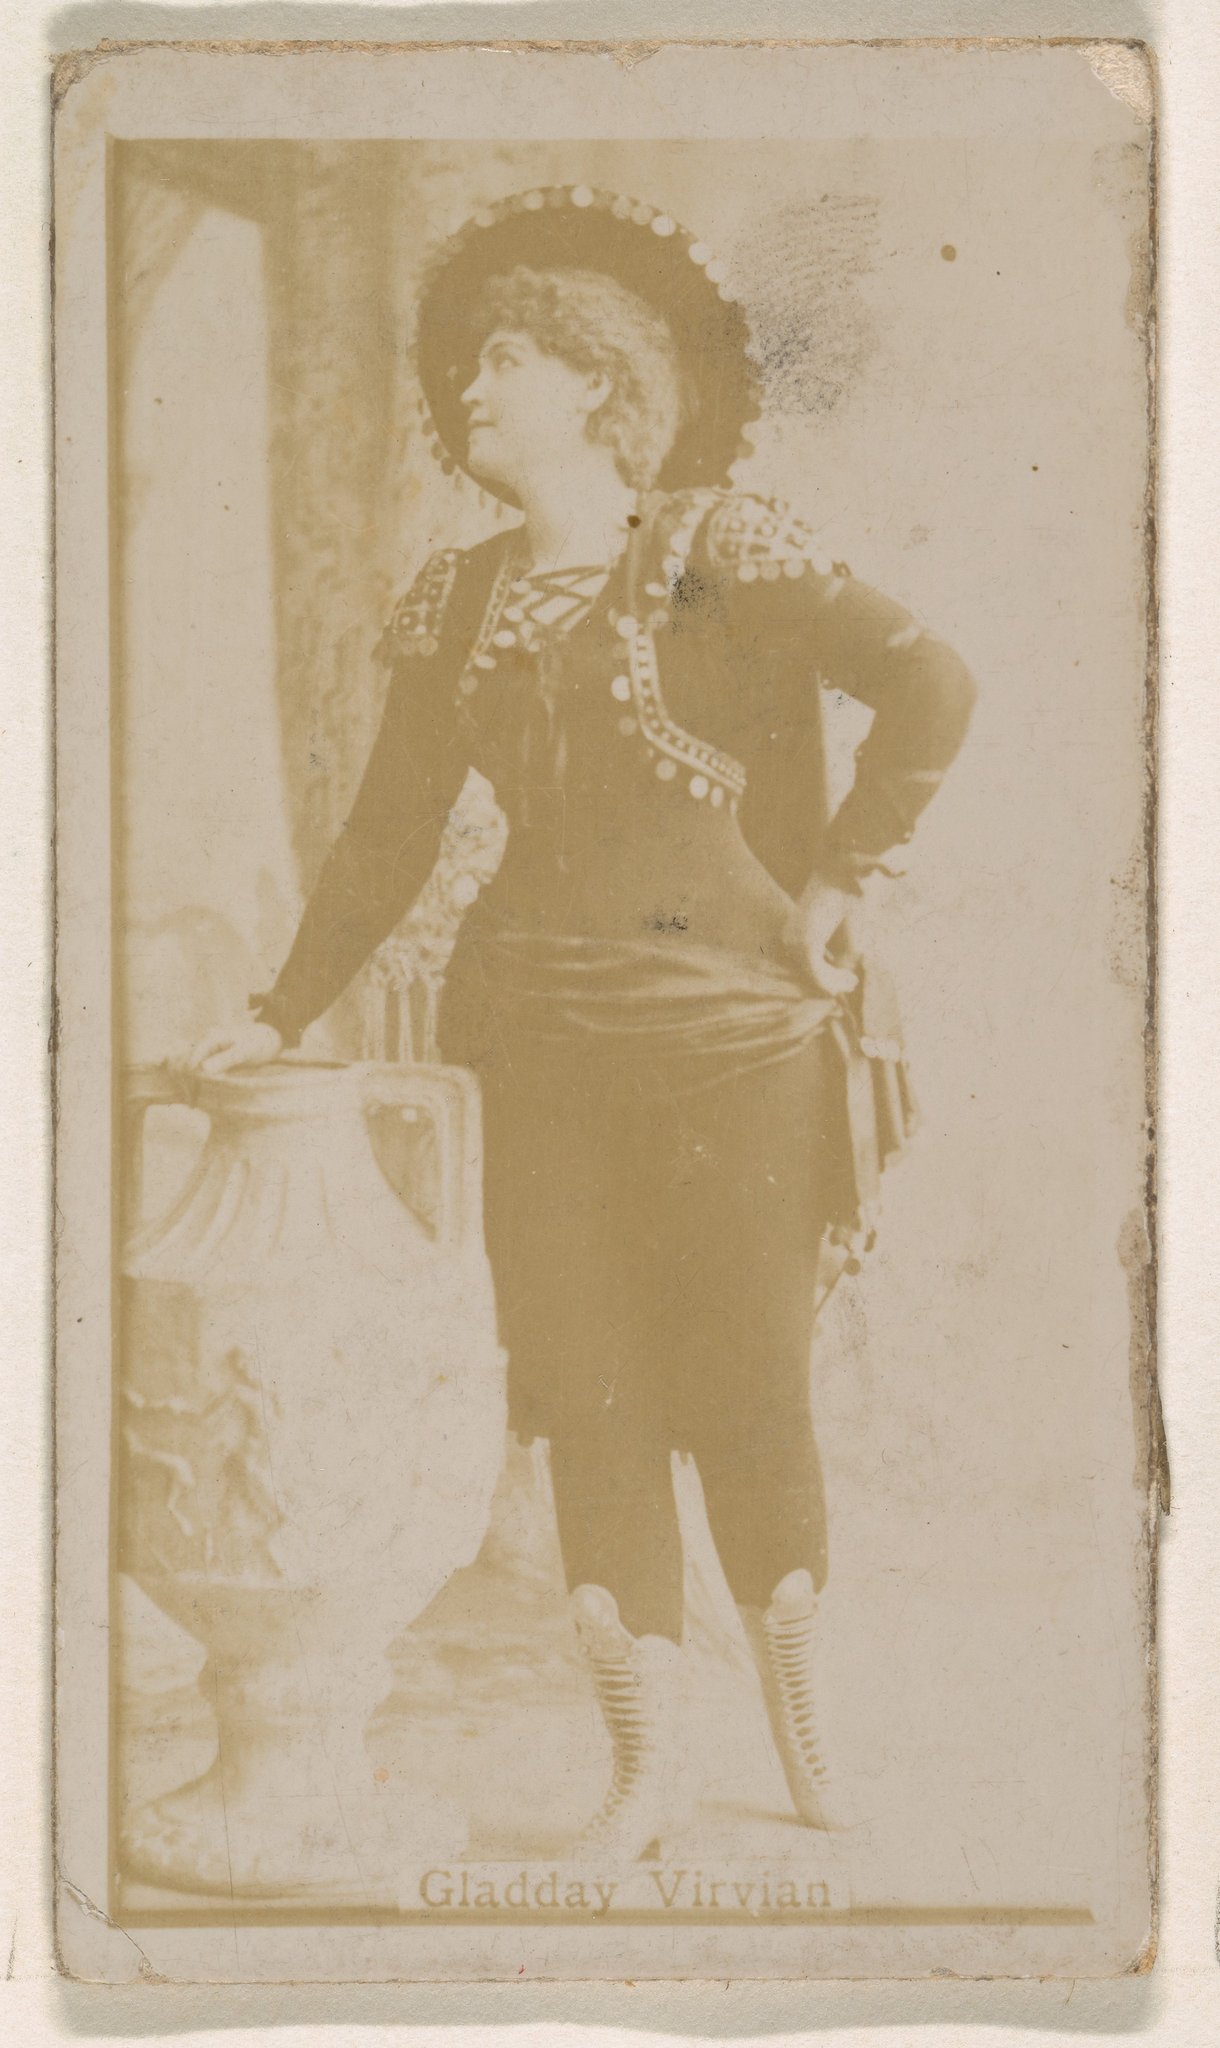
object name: photograph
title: Gladday Virvian, from the Actresses series (N245) issued by Kinney Brothers to promote Sweet Caporal Cigarettes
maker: kinney brothers tobacco company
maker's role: publisher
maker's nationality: american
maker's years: 1869-2011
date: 1890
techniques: albumen silver print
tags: women,actresses